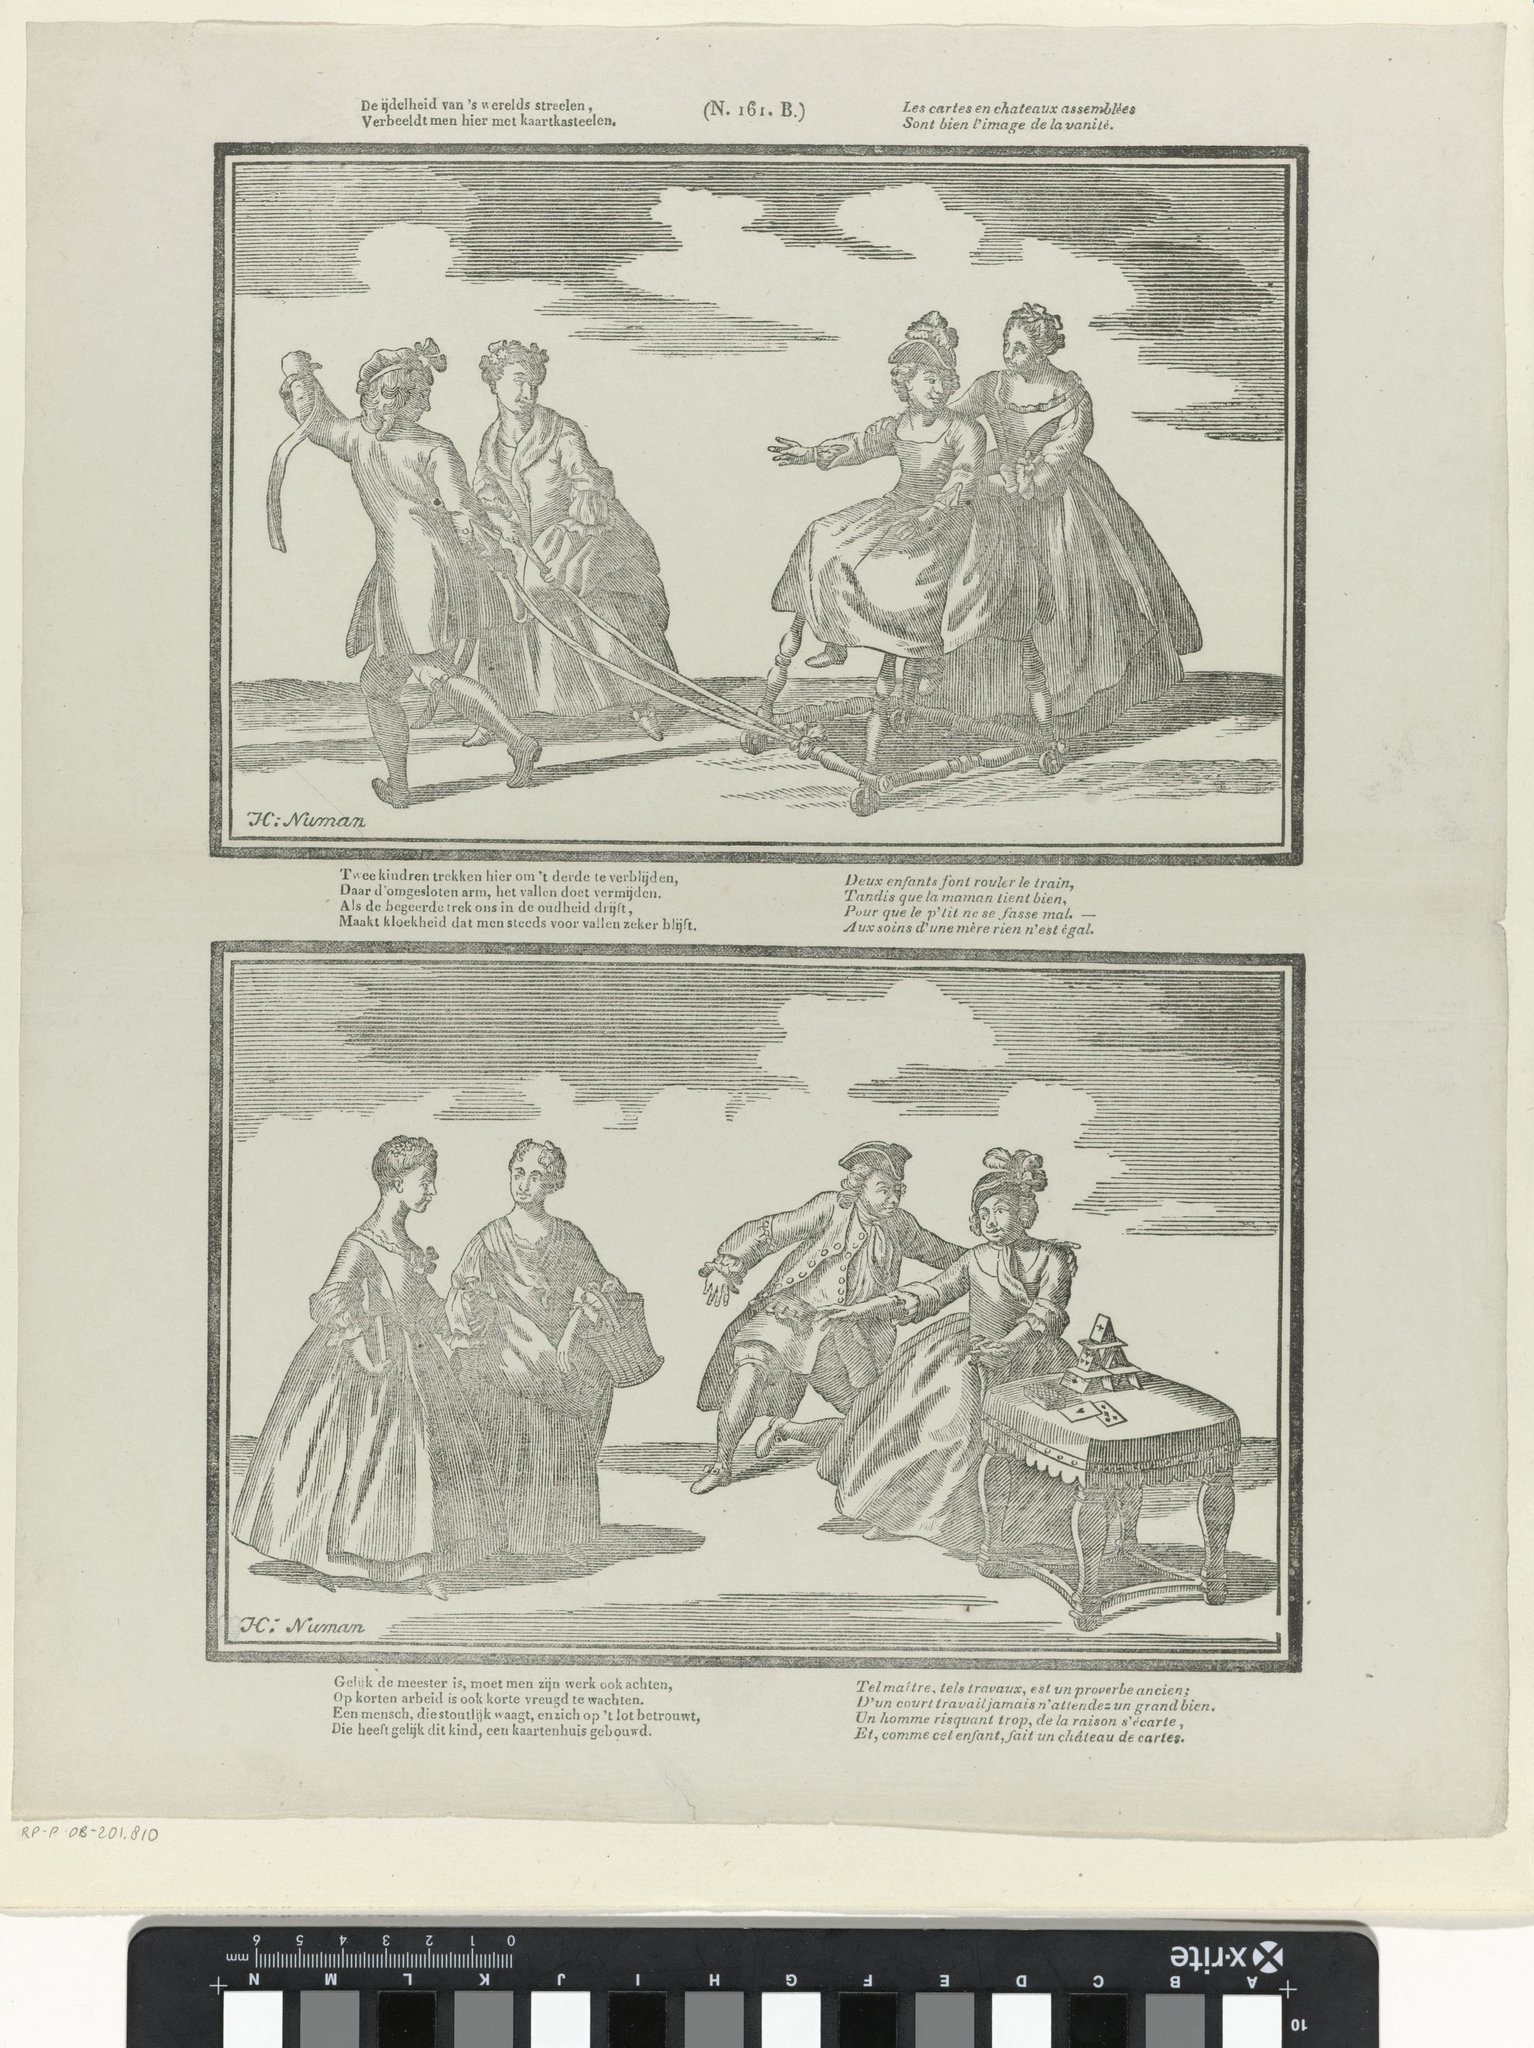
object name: print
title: De ijdelheid van 's werelds streelen, / Verbeeldt men hier met kaartkasteelen / Les cartes en chateaux assemblées / Sont bien l´image de la vanité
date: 1800-1833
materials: paper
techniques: letterpress printing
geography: turnhout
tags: children's games and plays, playing-cards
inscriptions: collector's mark: Lugt 2760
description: Blad met 2 voorstellingen van spelende kinderen. Boven trekken twee kinderen een meid op een kar vooruit. Onder bouwt een meid een kaartenhuis. Onder elke afbeelding een vierregelig vers in het Nederlands en in het Frans. Genummerd midden boven: (N. 161. B.).